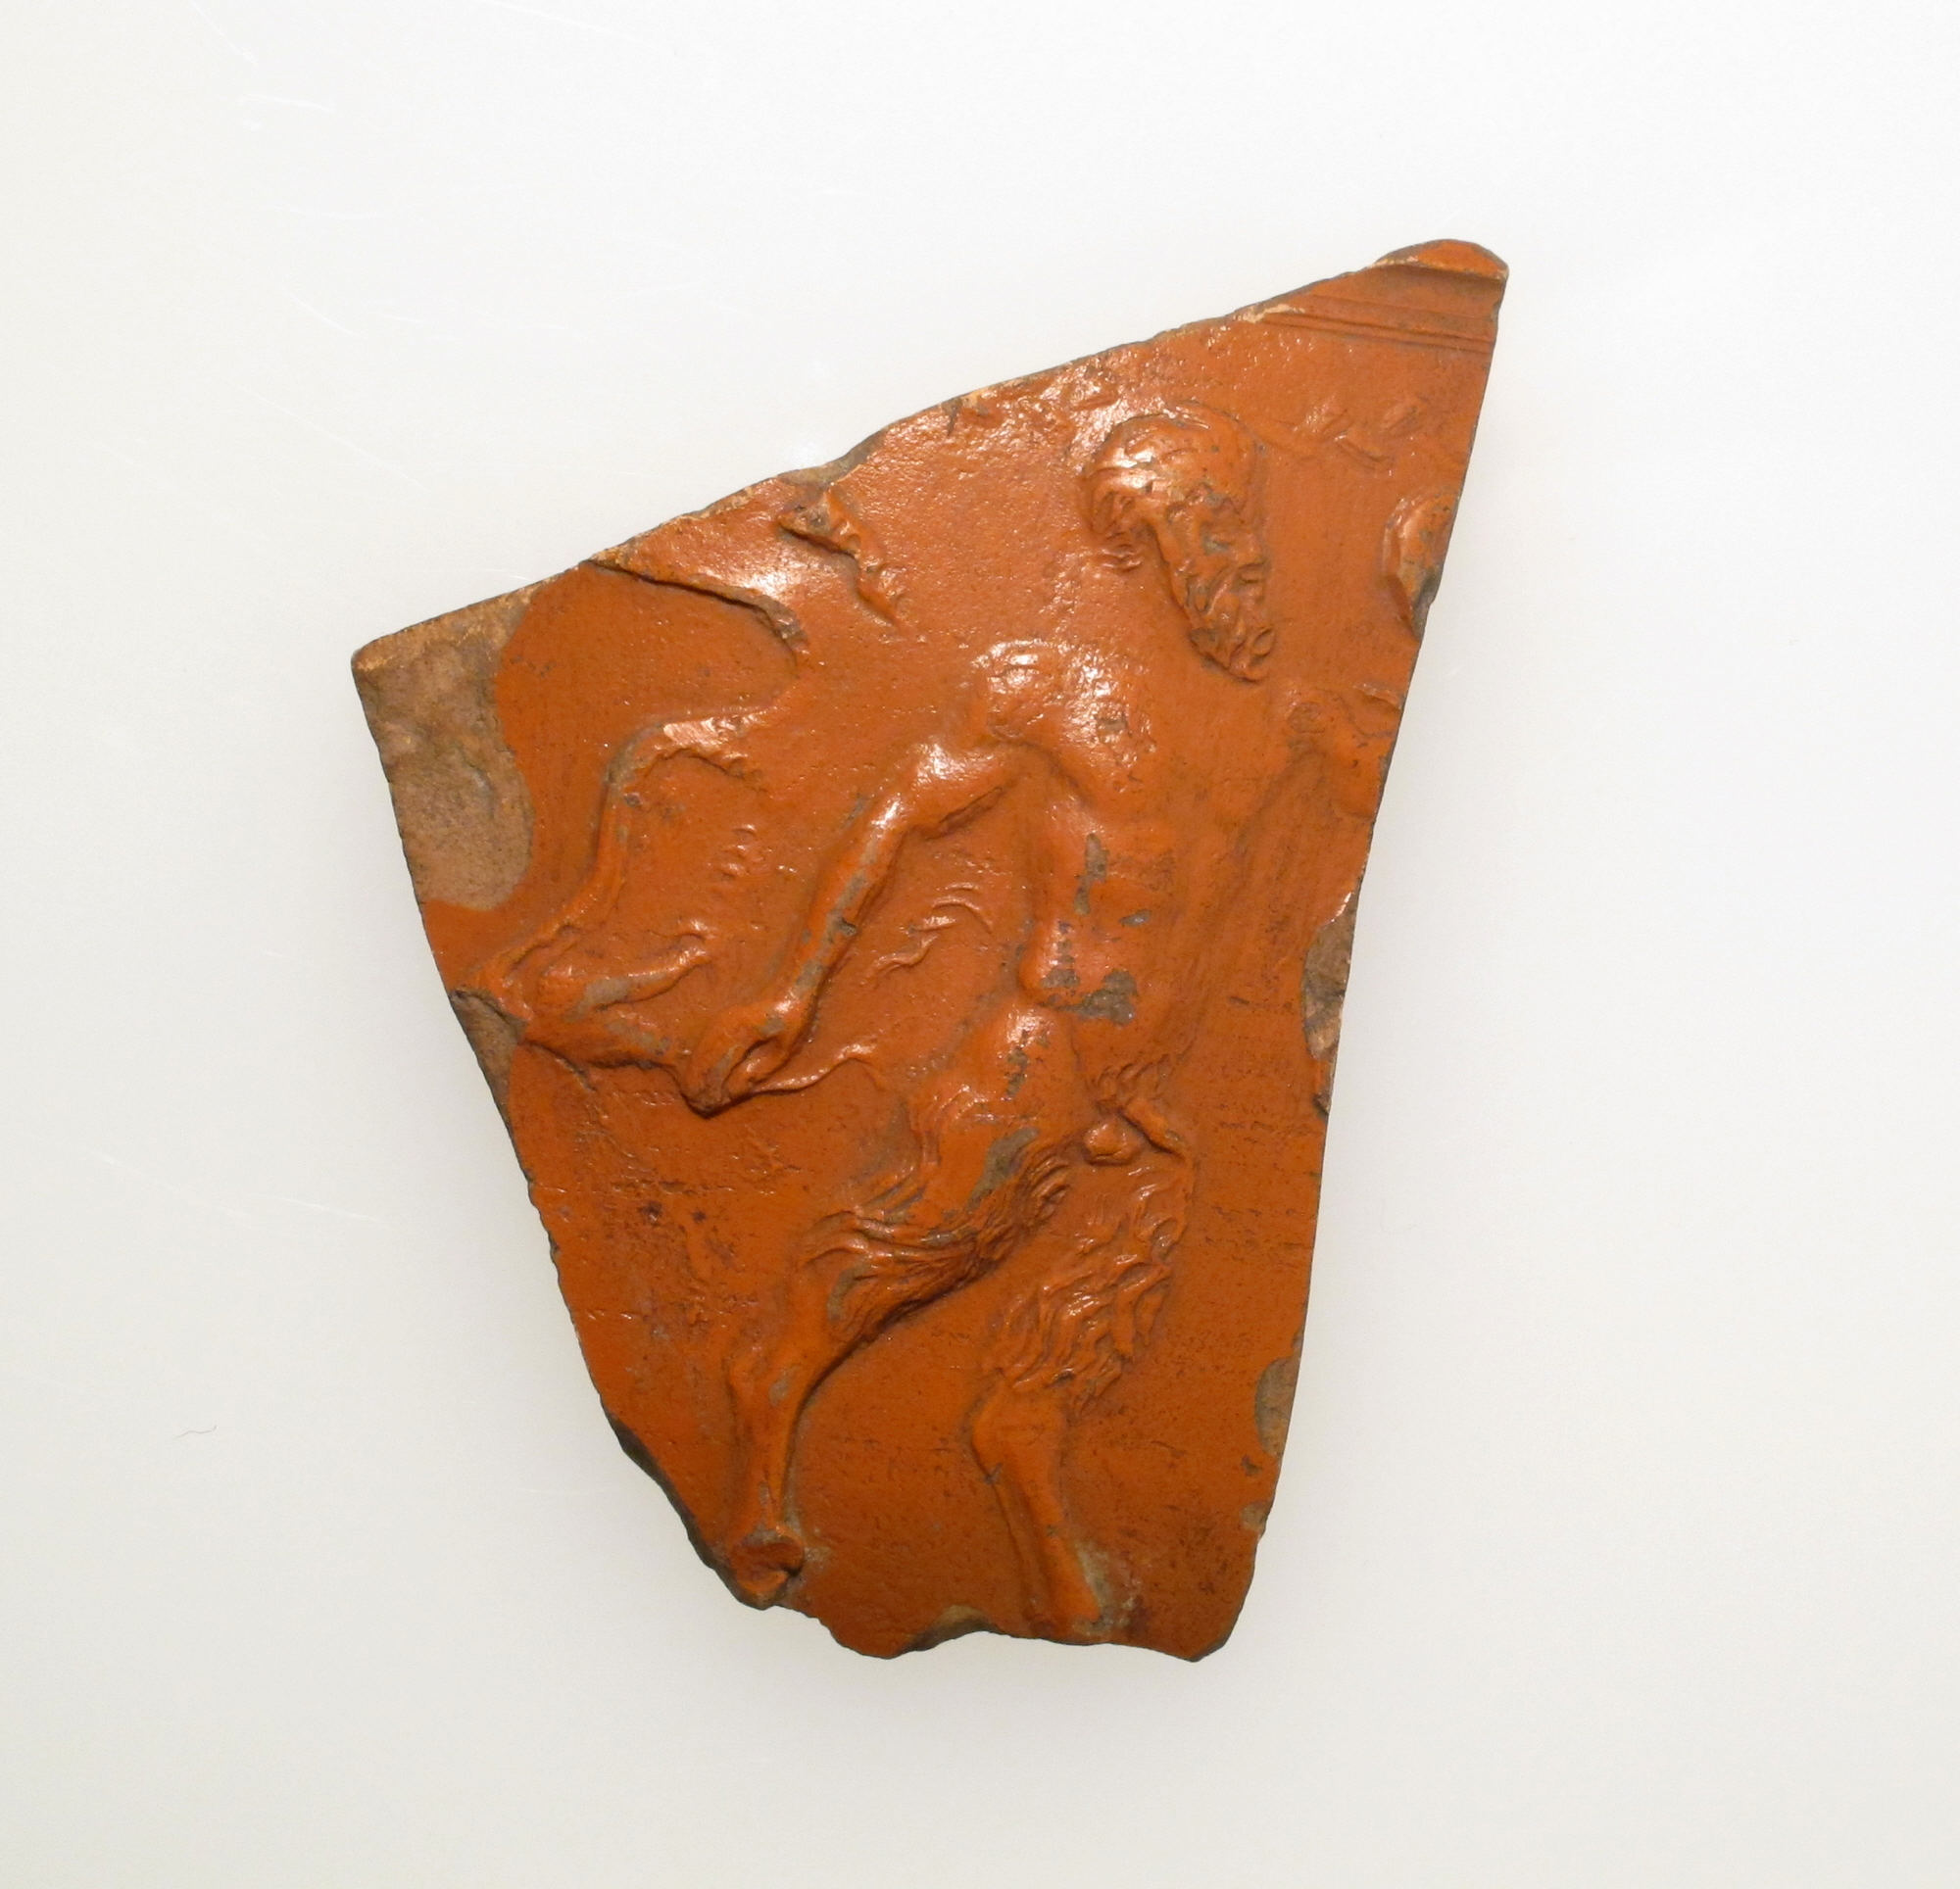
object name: vase fragment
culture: roman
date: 100 BCE-100 CE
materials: terracotta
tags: satyrs